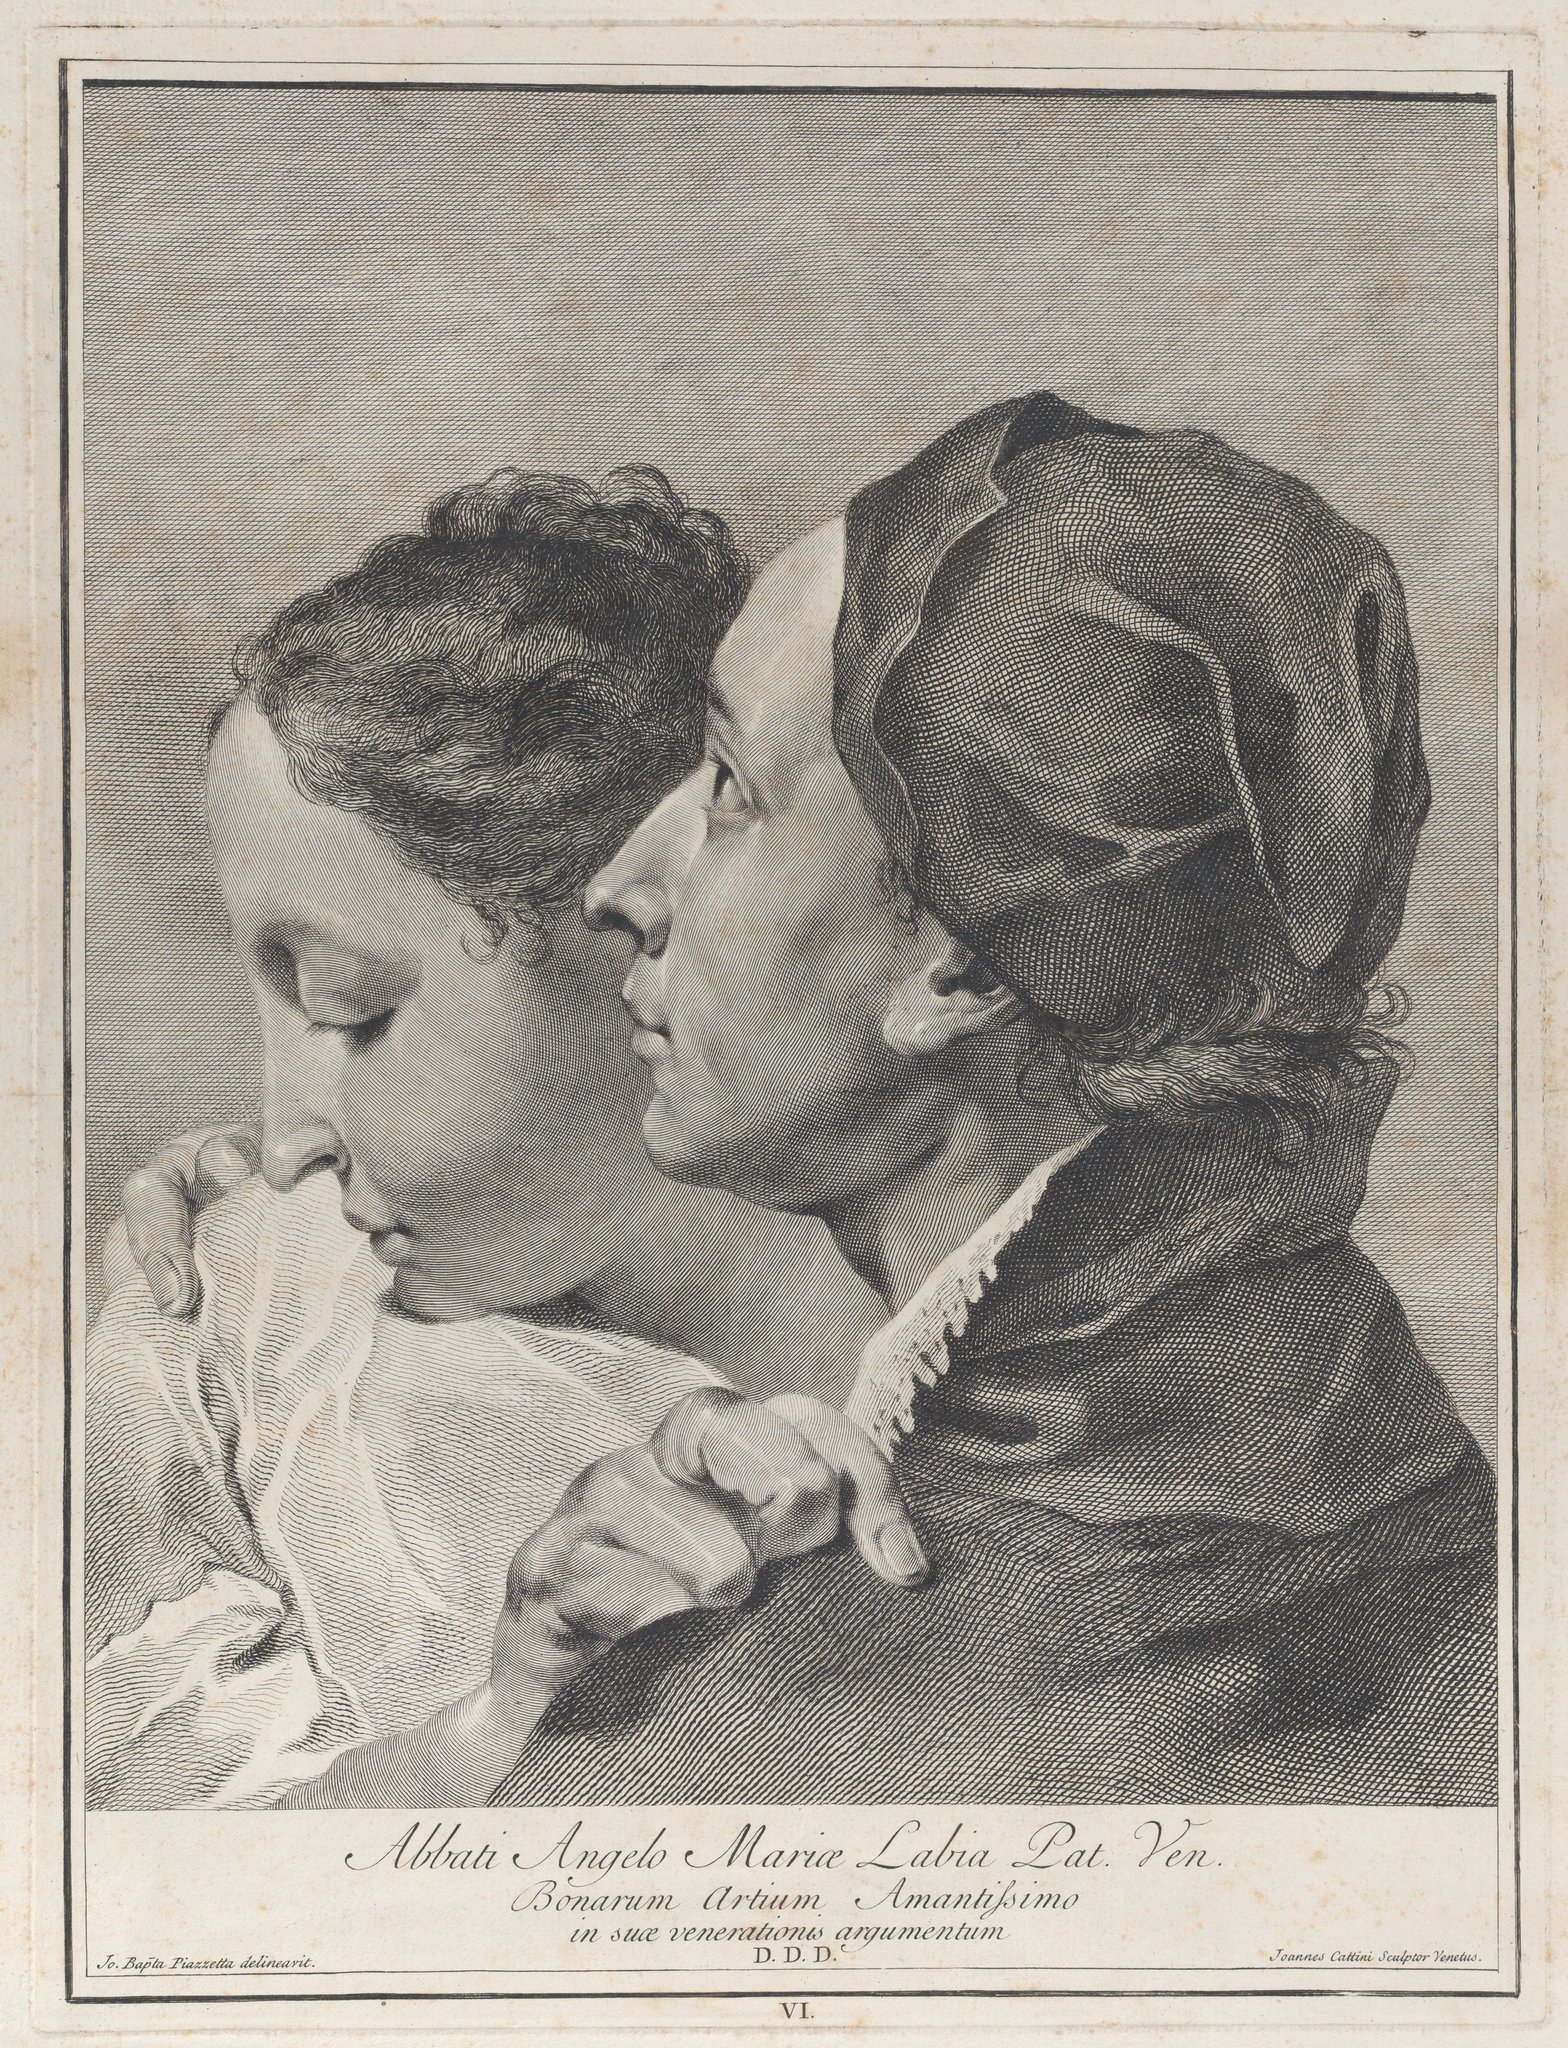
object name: print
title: Plate 6: A young man embracing a girl, from "Icones ad vivum expressae"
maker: giovanni cattini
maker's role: artist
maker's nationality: italian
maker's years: 1715-1800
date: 1743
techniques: etching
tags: men,women